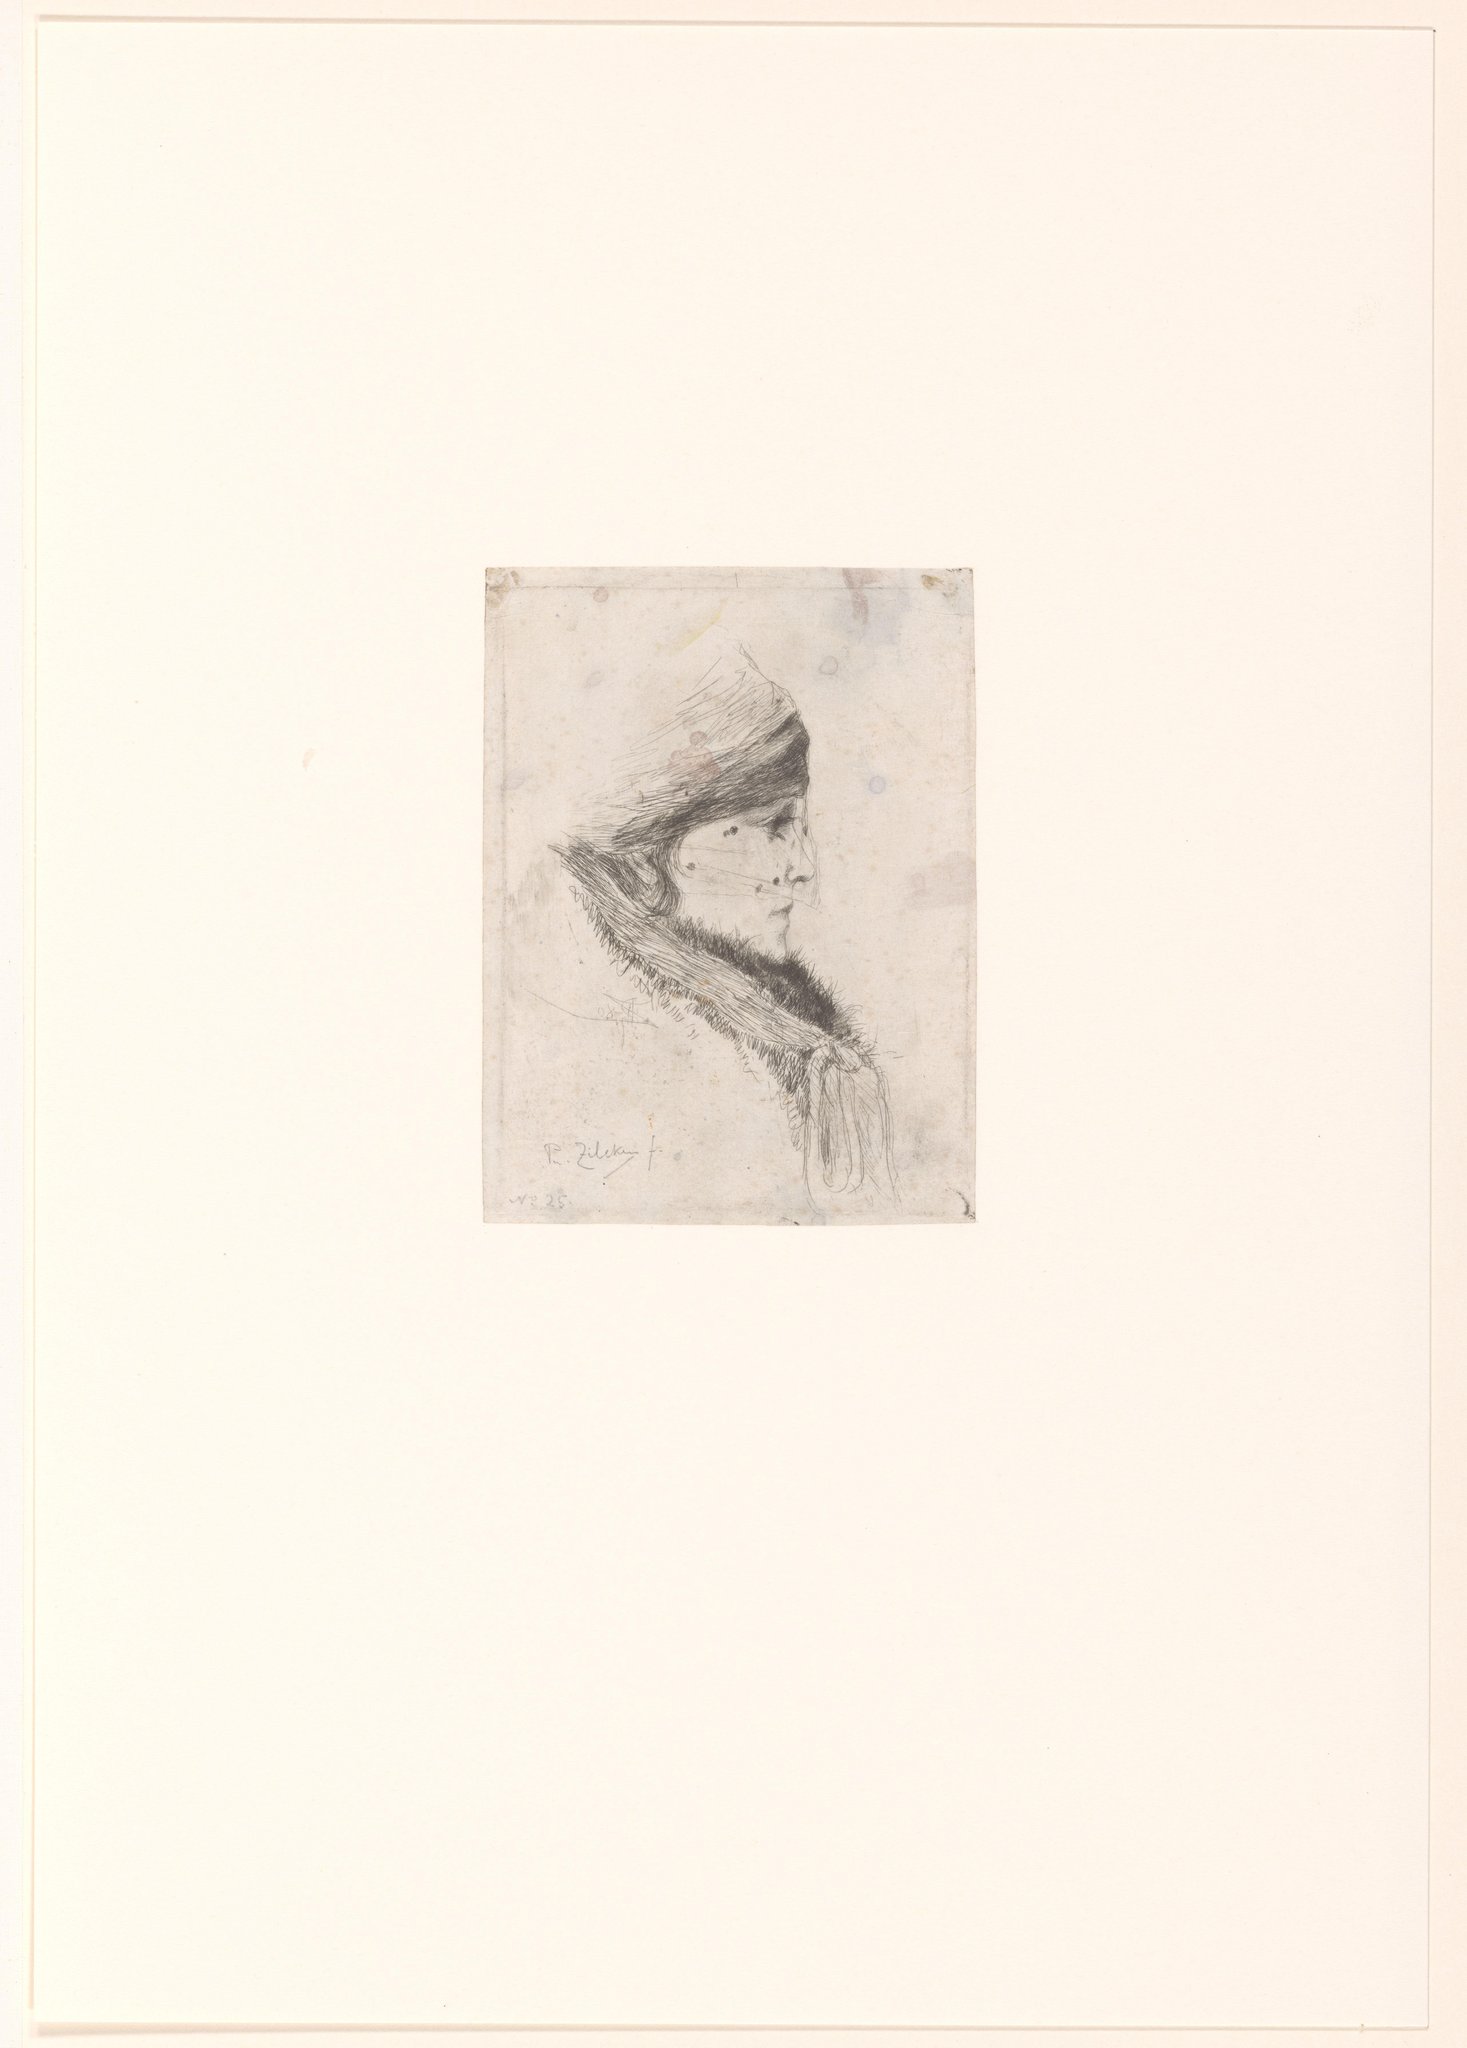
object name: print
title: Hoofd van een jonge vrouw, en profil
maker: philip zilcken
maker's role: draughtsman, painter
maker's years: 1857-1930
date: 1867-1890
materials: paper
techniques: drypoint, etching, intaglio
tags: adult woman, fashionable woman, 'belle'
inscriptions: collector's mark: Lugt 2228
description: Volgens de catalogus heet de geportretteerde 'Marianne'.